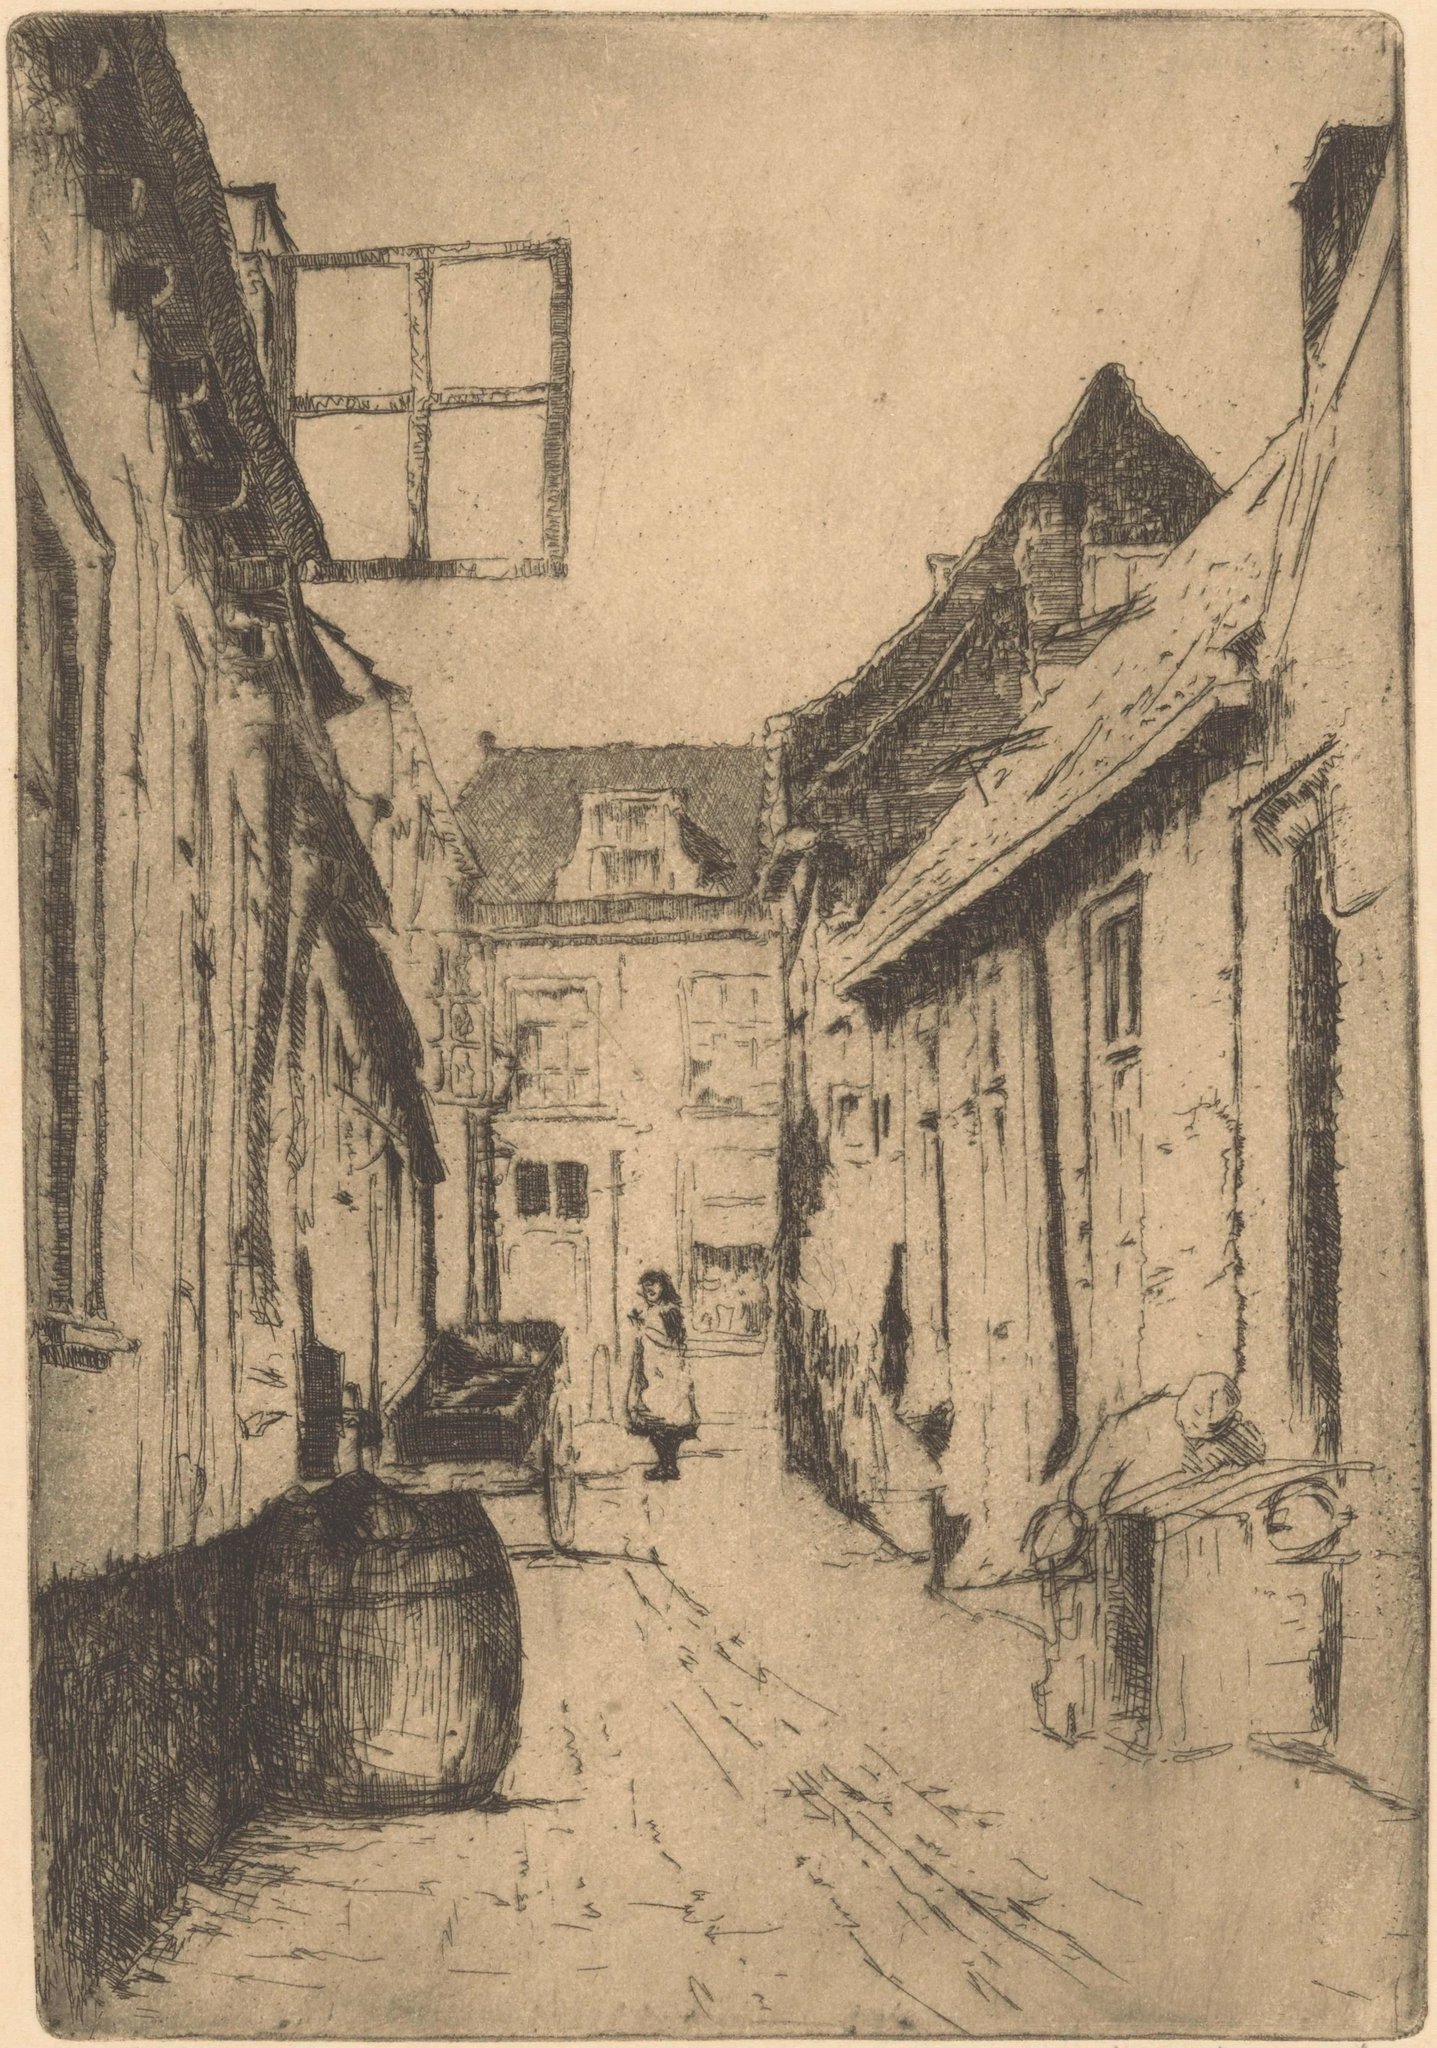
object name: print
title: Straatje in Voorburg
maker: willem adrianus grondhout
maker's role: draughtsman, painter, print maker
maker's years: 1878-1934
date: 1888-1934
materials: paper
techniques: etching, intaglio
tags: street, voorburg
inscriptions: collector's mark: Lugt 2228, number: ‘13’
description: Op de voorgrond een regenton bij een huis met geopend raam. Aan het einde van de straat een vrouw en een kar.